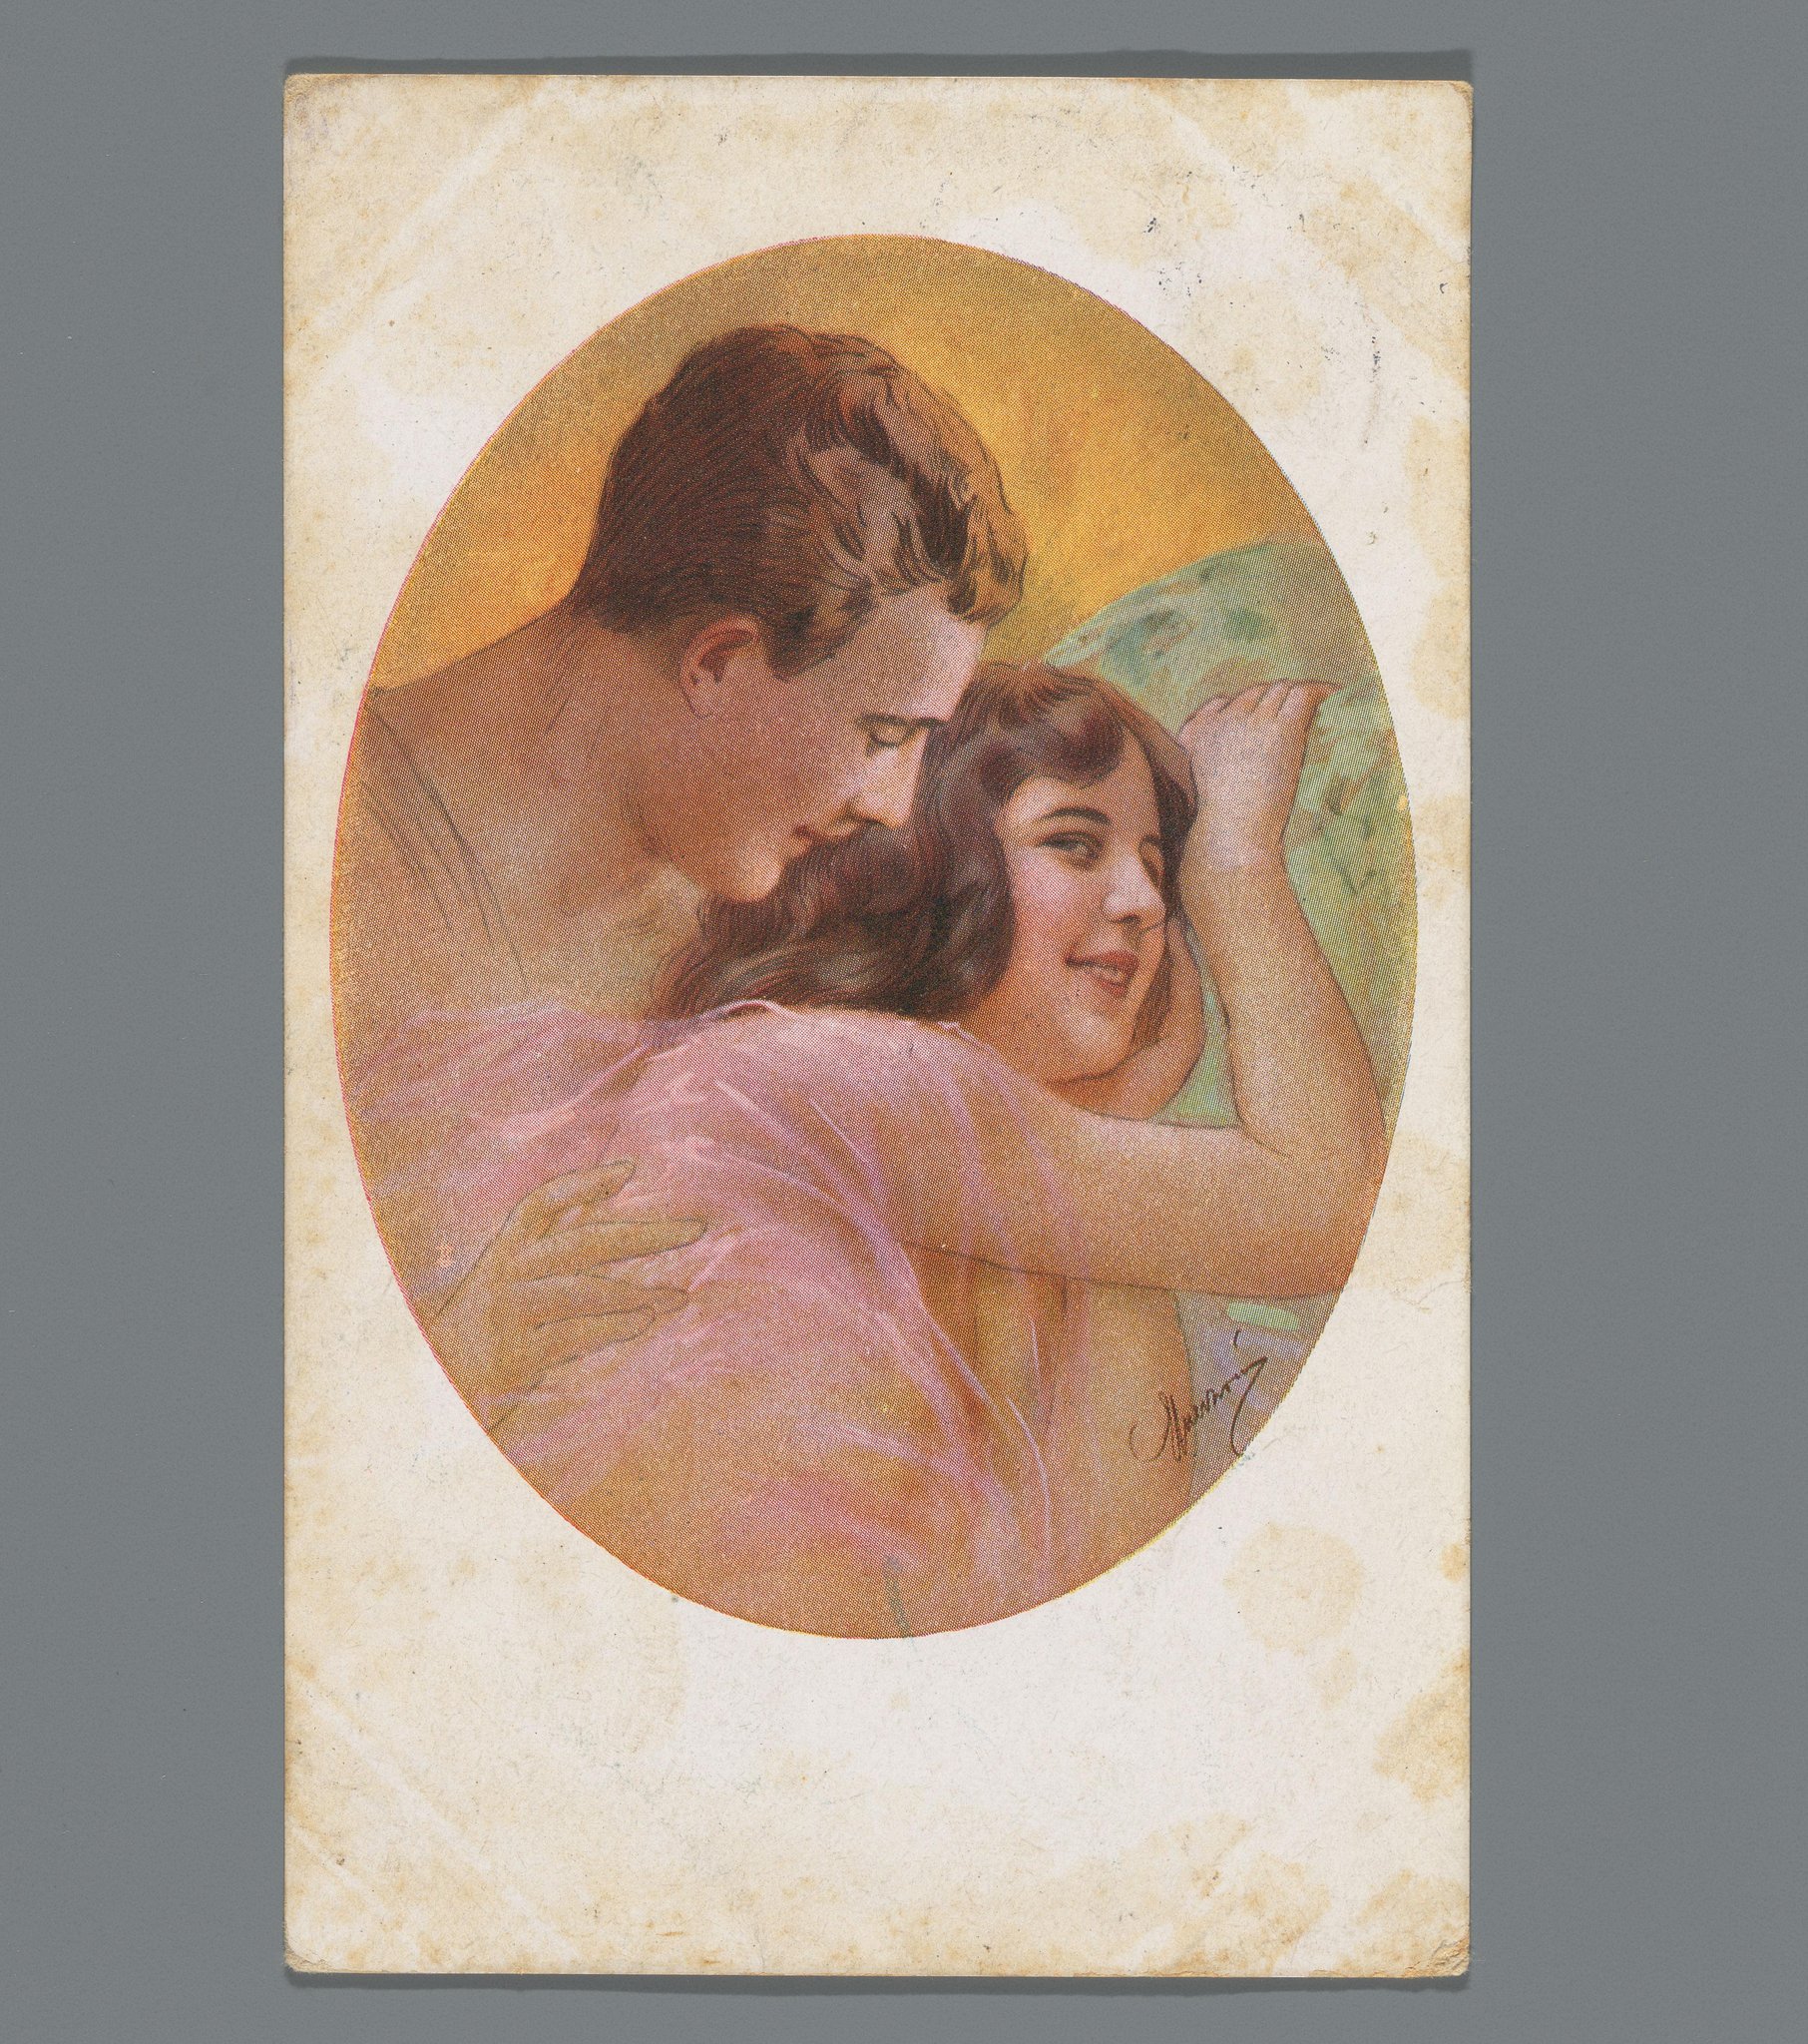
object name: reproduction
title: Verliefd paar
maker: Anonymous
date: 1926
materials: paper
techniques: writing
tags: couple of lovers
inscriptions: number: ‘4717’, number: ‘Serie 1033-6’